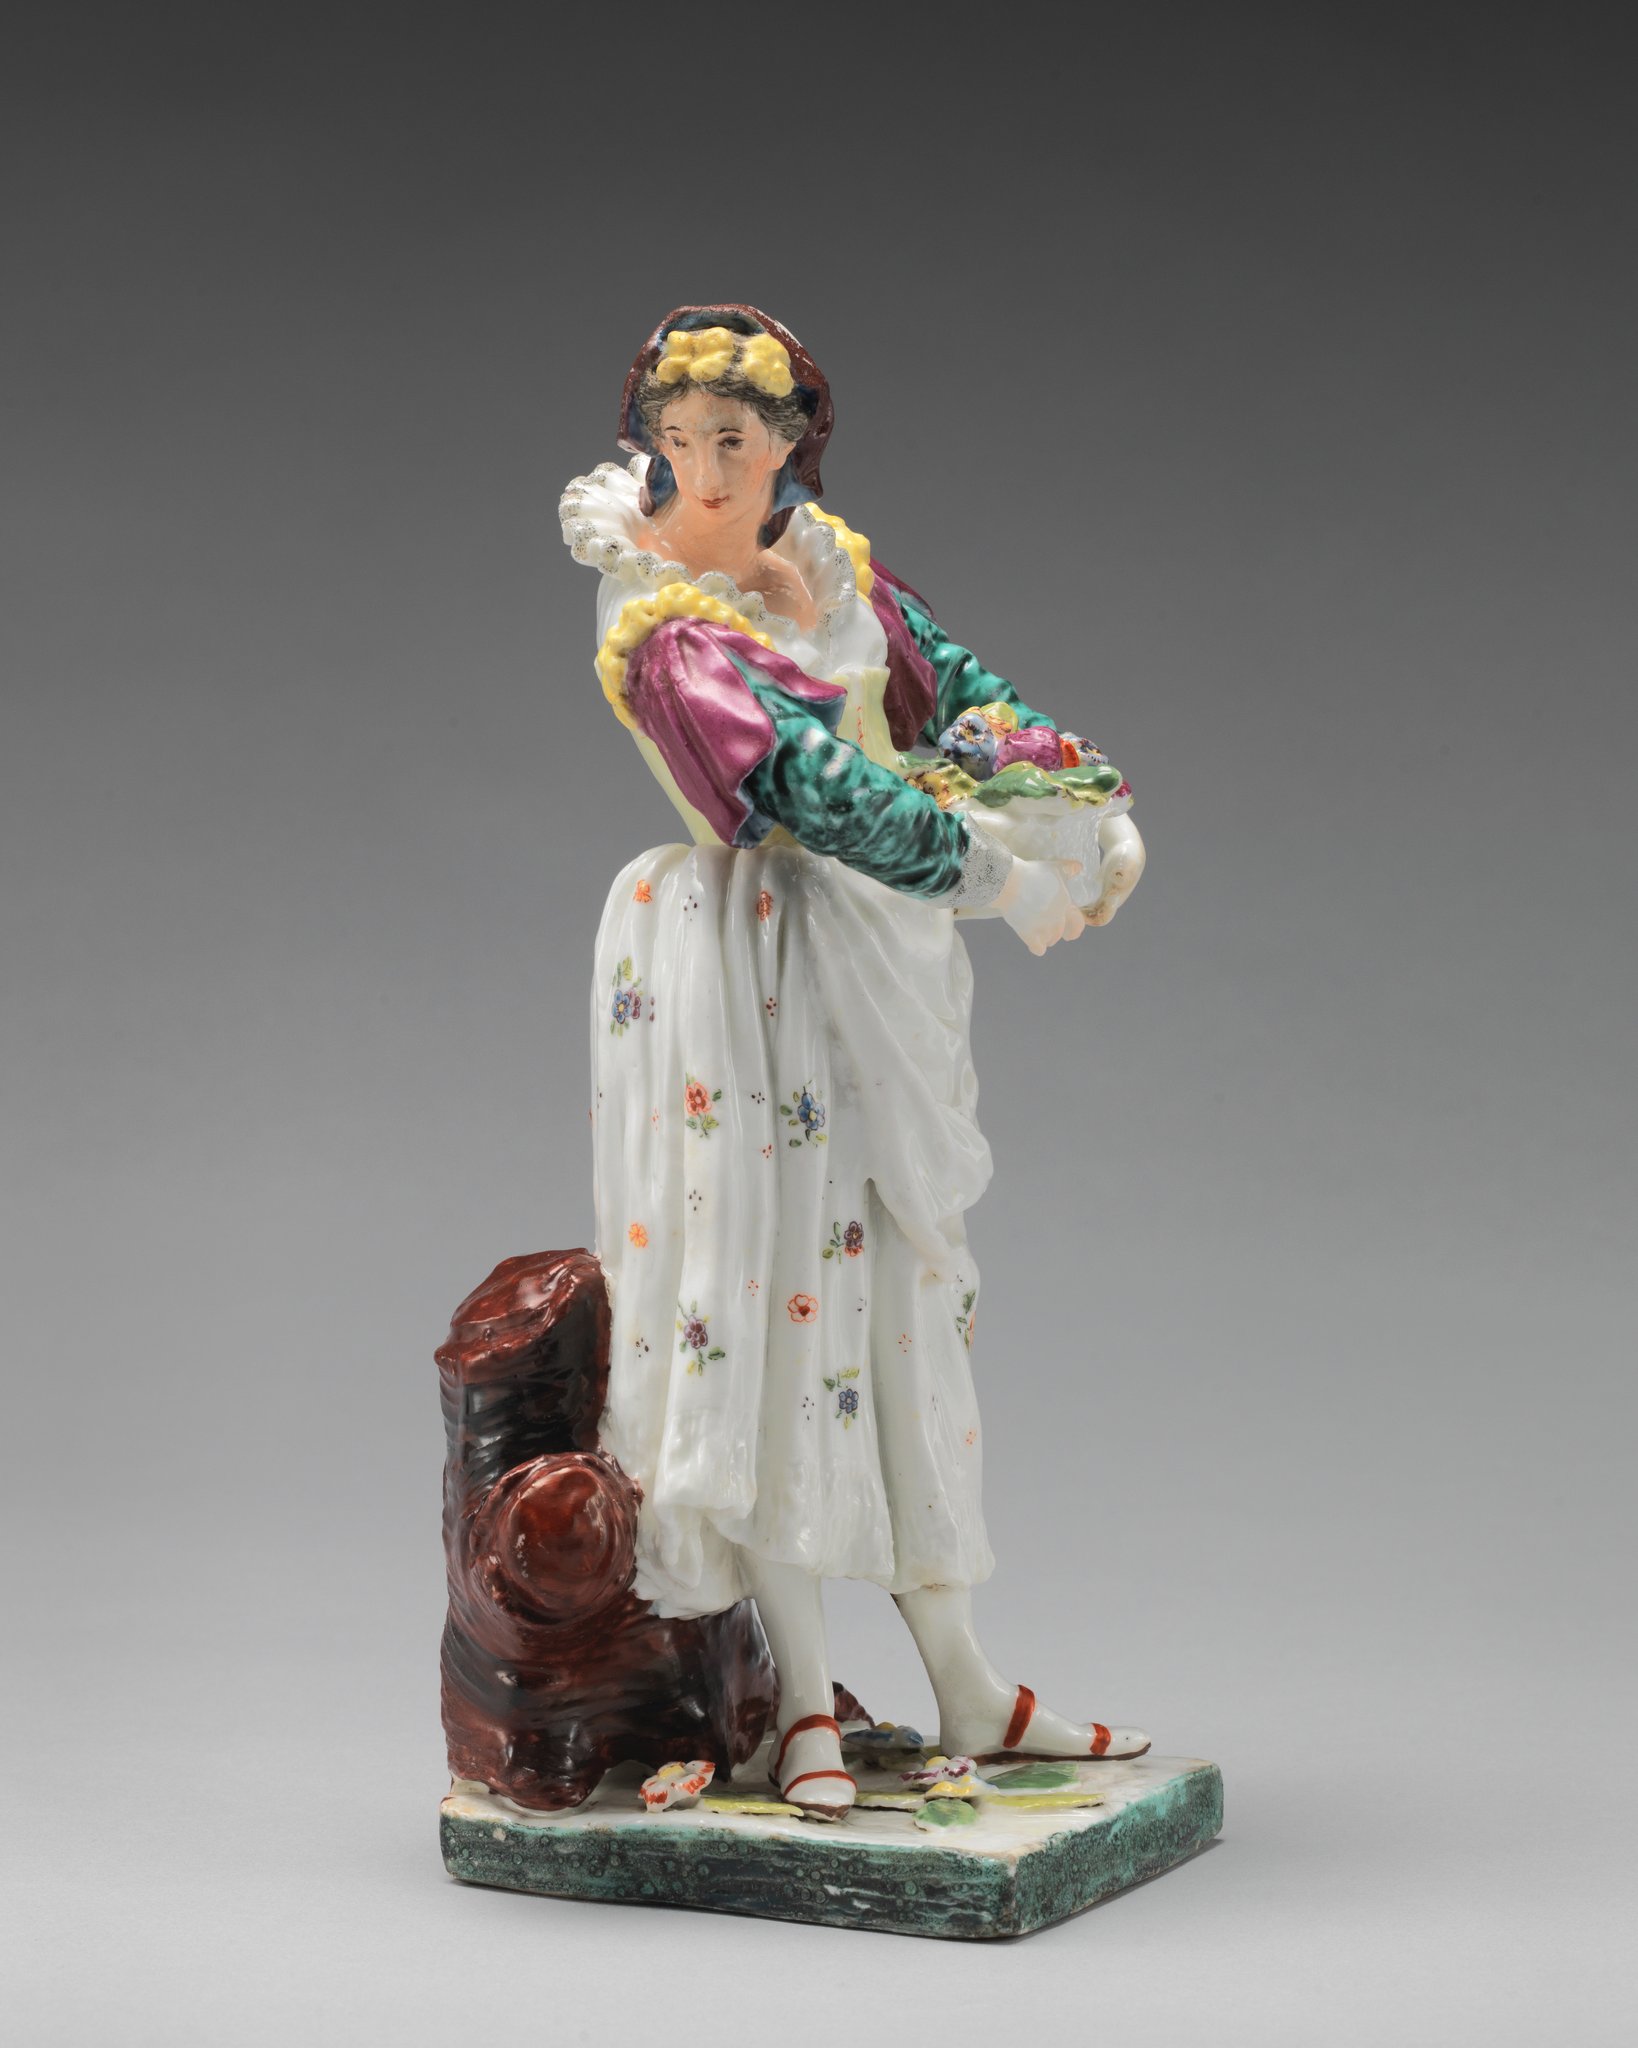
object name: figure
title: Woman carrying a basket of flowers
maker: chelsea porcelain manufactory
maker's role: factory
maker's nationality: british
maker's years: 1744-1784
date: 1701-1800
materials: soft paste porcelain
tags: women,flowers